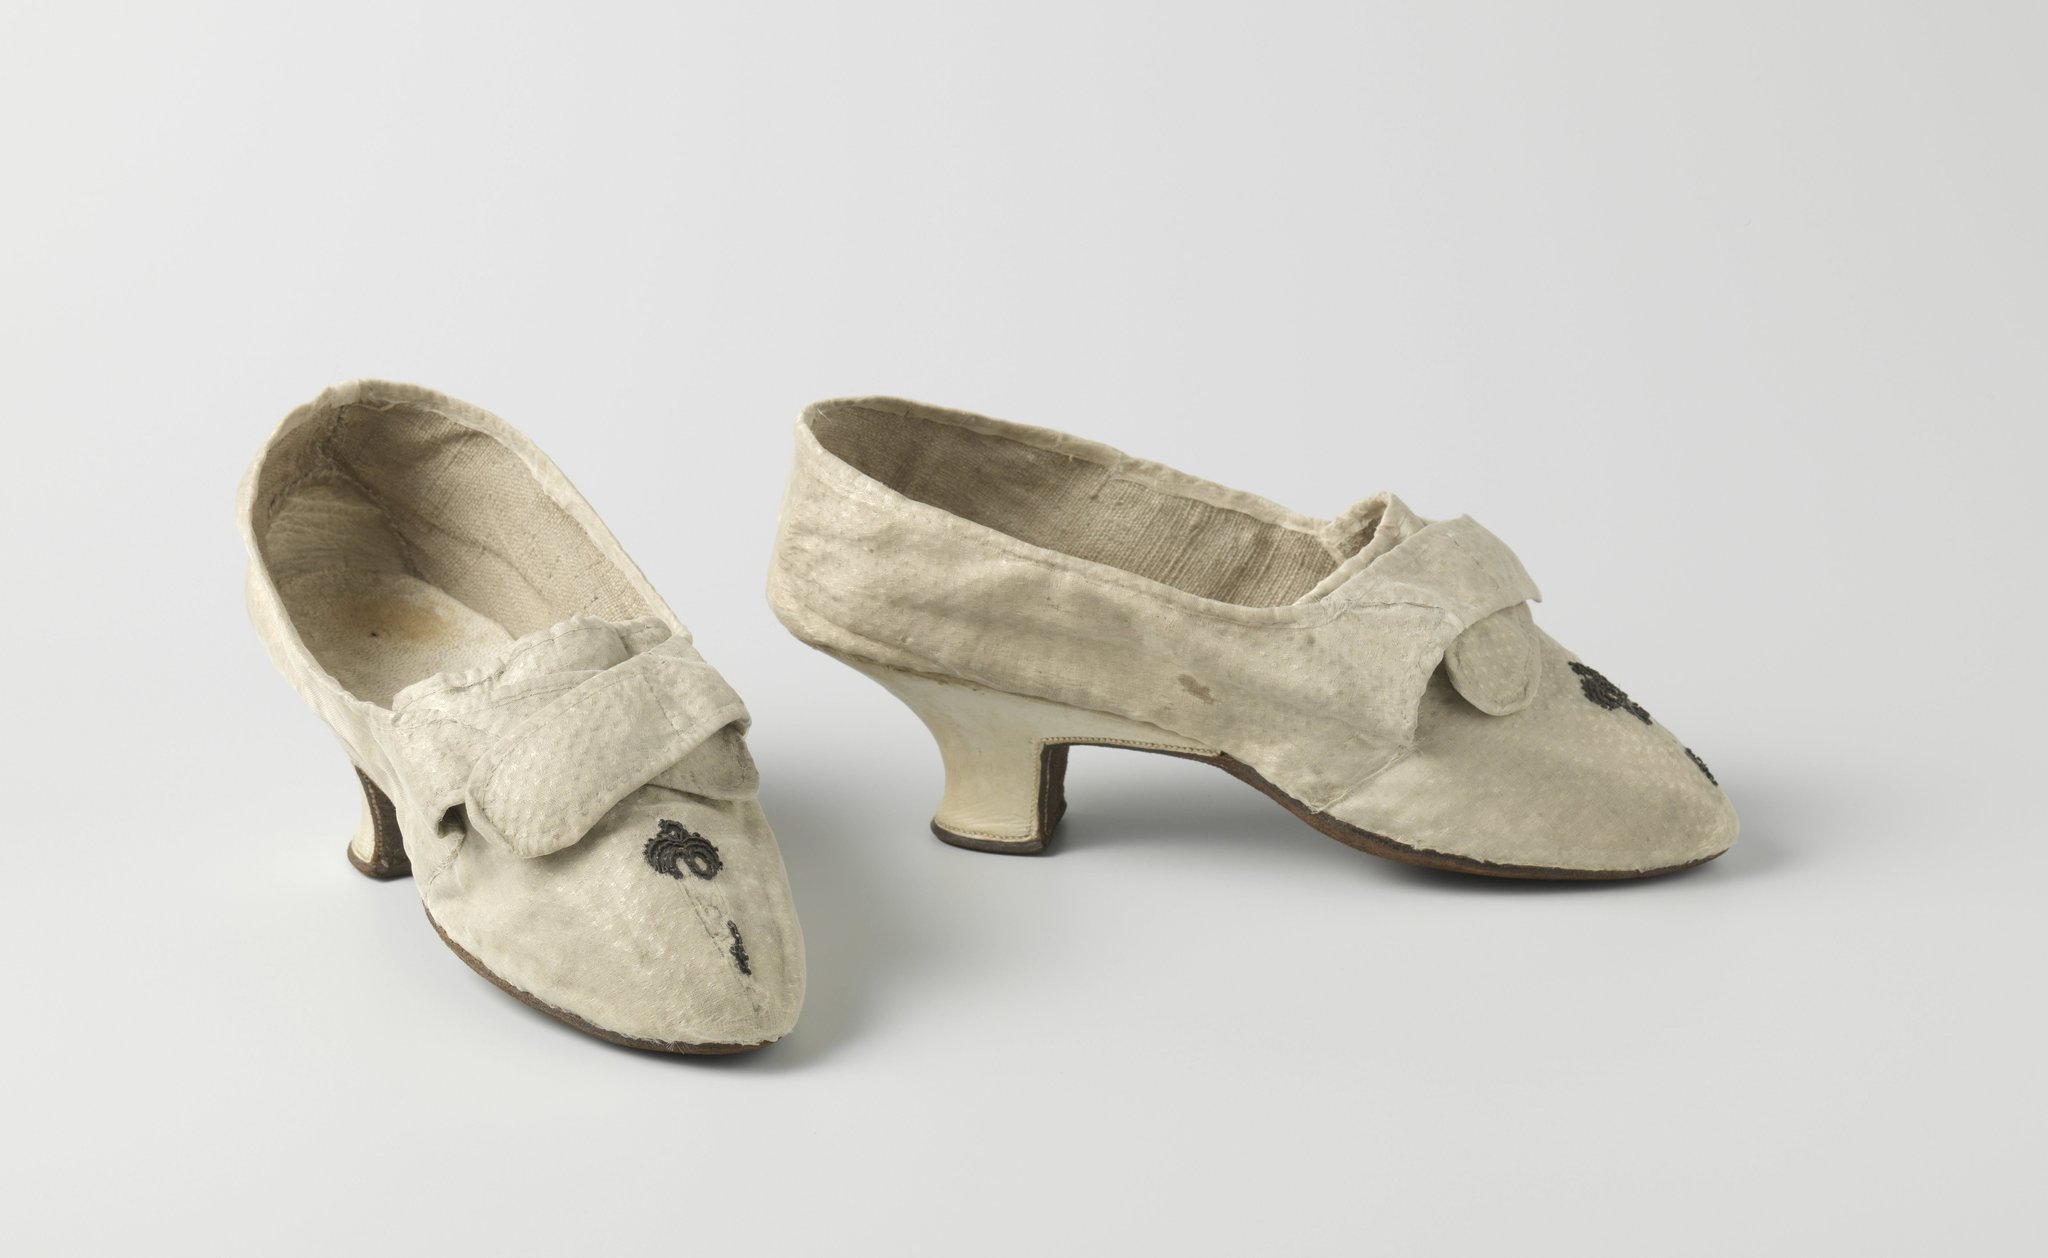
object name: womenswear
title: Damesschoen van crèmekleurig genopte zijde, op de neus versierd met zilveren lovers en canetille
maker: Anonymous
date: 1770-1780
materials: leather, linen, silk, silver, wood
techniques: tanning, weave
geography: netherlands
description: Damesschoen van crèmekleurig genopte zijde. Afgeronde neus, één voorblad en twee zijbladen.Op de stikseld, die de bladen bij elkaar houden, hebben oorspronkelijk crèmekleurige banden gezeten. Vierkante tong op de wreef. Over de tong lopen vanaf de zijbladen twee flappen kruislings over elkaar. De voorkant van de hak loopt vanaf het geleng in een rechte hoek recht naar beneden. De zijkant en achterkant van de hak zijn getailleerd en bekleed met crèmekleurig leer. De hak heeft een donkerbruine rand leer van het achterlapje. Zijbladen en voorblad gevoerd met beige linnen. In de hiel is een afgerond stuk ivoorwit leer bevestigd. De binnenzool is van ivoorwit leer. Leren achterlapje met houten spijkers aan de hak vastgeslagen en geruwd leren zool. Versiering: Midden op het voorblad van de punt tot halverwege de voorvoet is een versiering van zilveren lovers en canetille. Afgebiesd met crèmekleurige zijde. Geen links/rechts verschil.